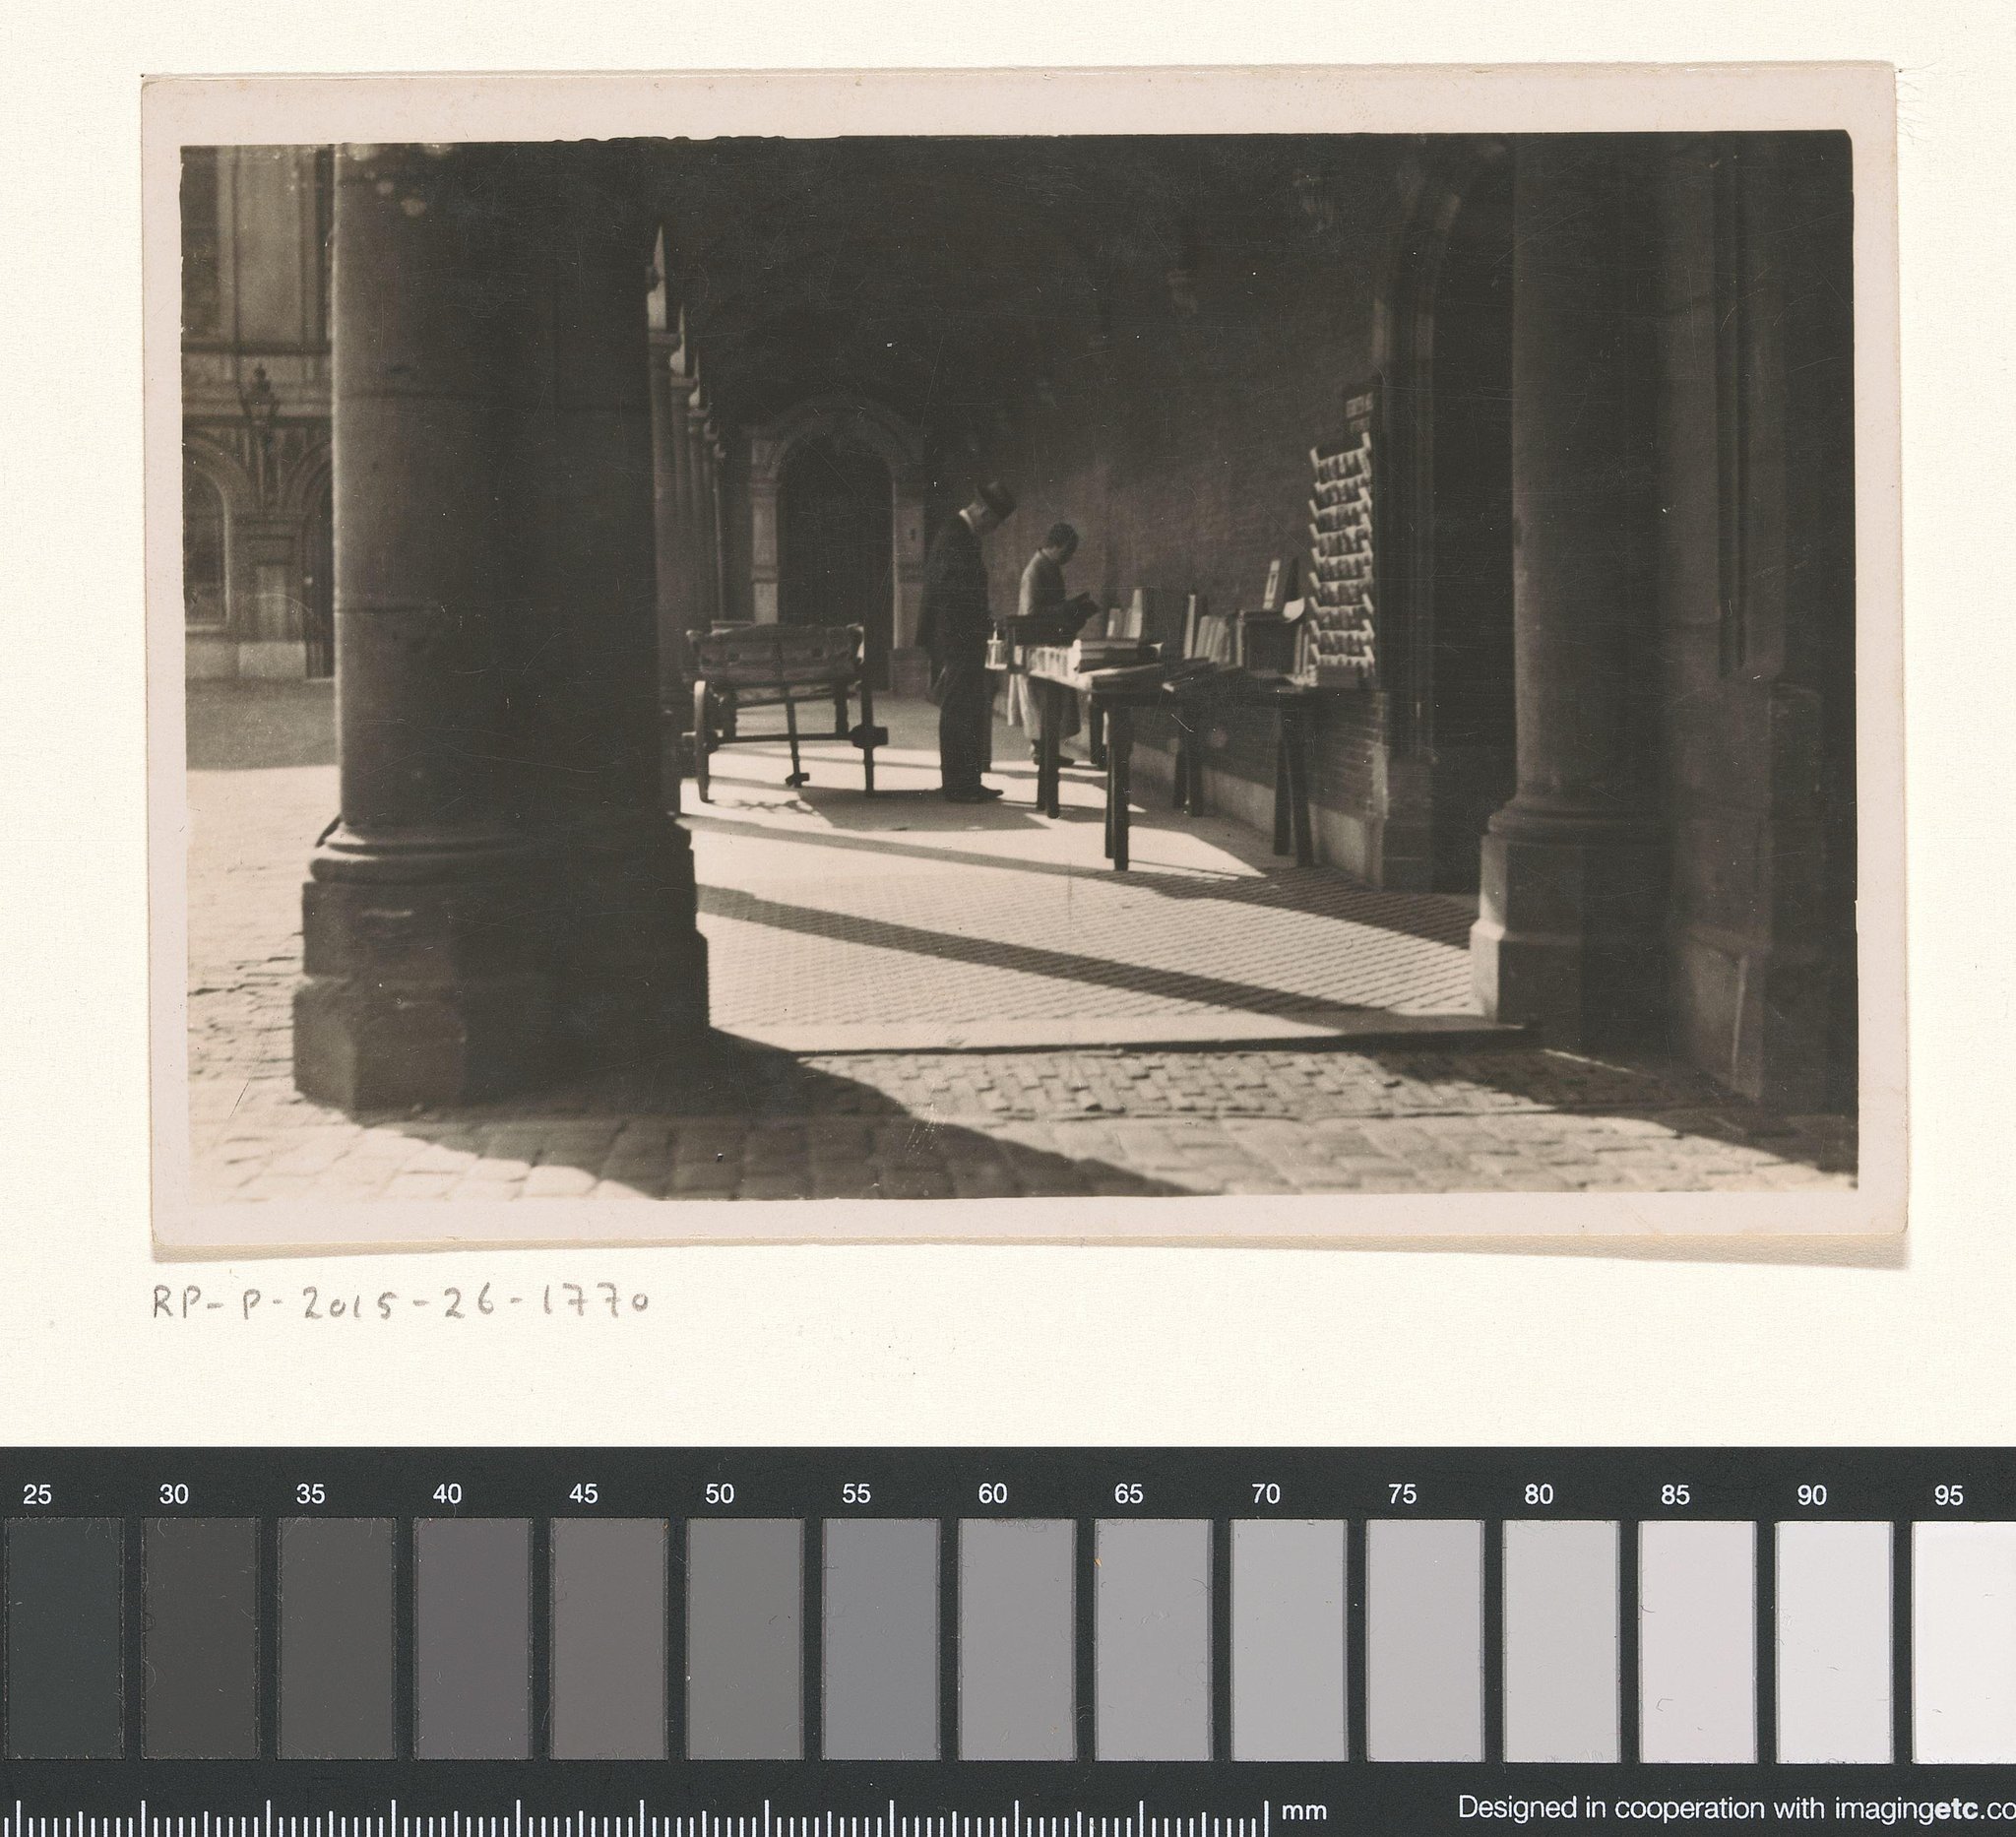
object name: photograph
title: Boekenkraam op het Binnenhof te Den Haag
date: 1900-1940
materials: paper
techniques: gelatin silver print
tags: book-stall, kiosk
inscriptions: collector's mark: Lugt 2228